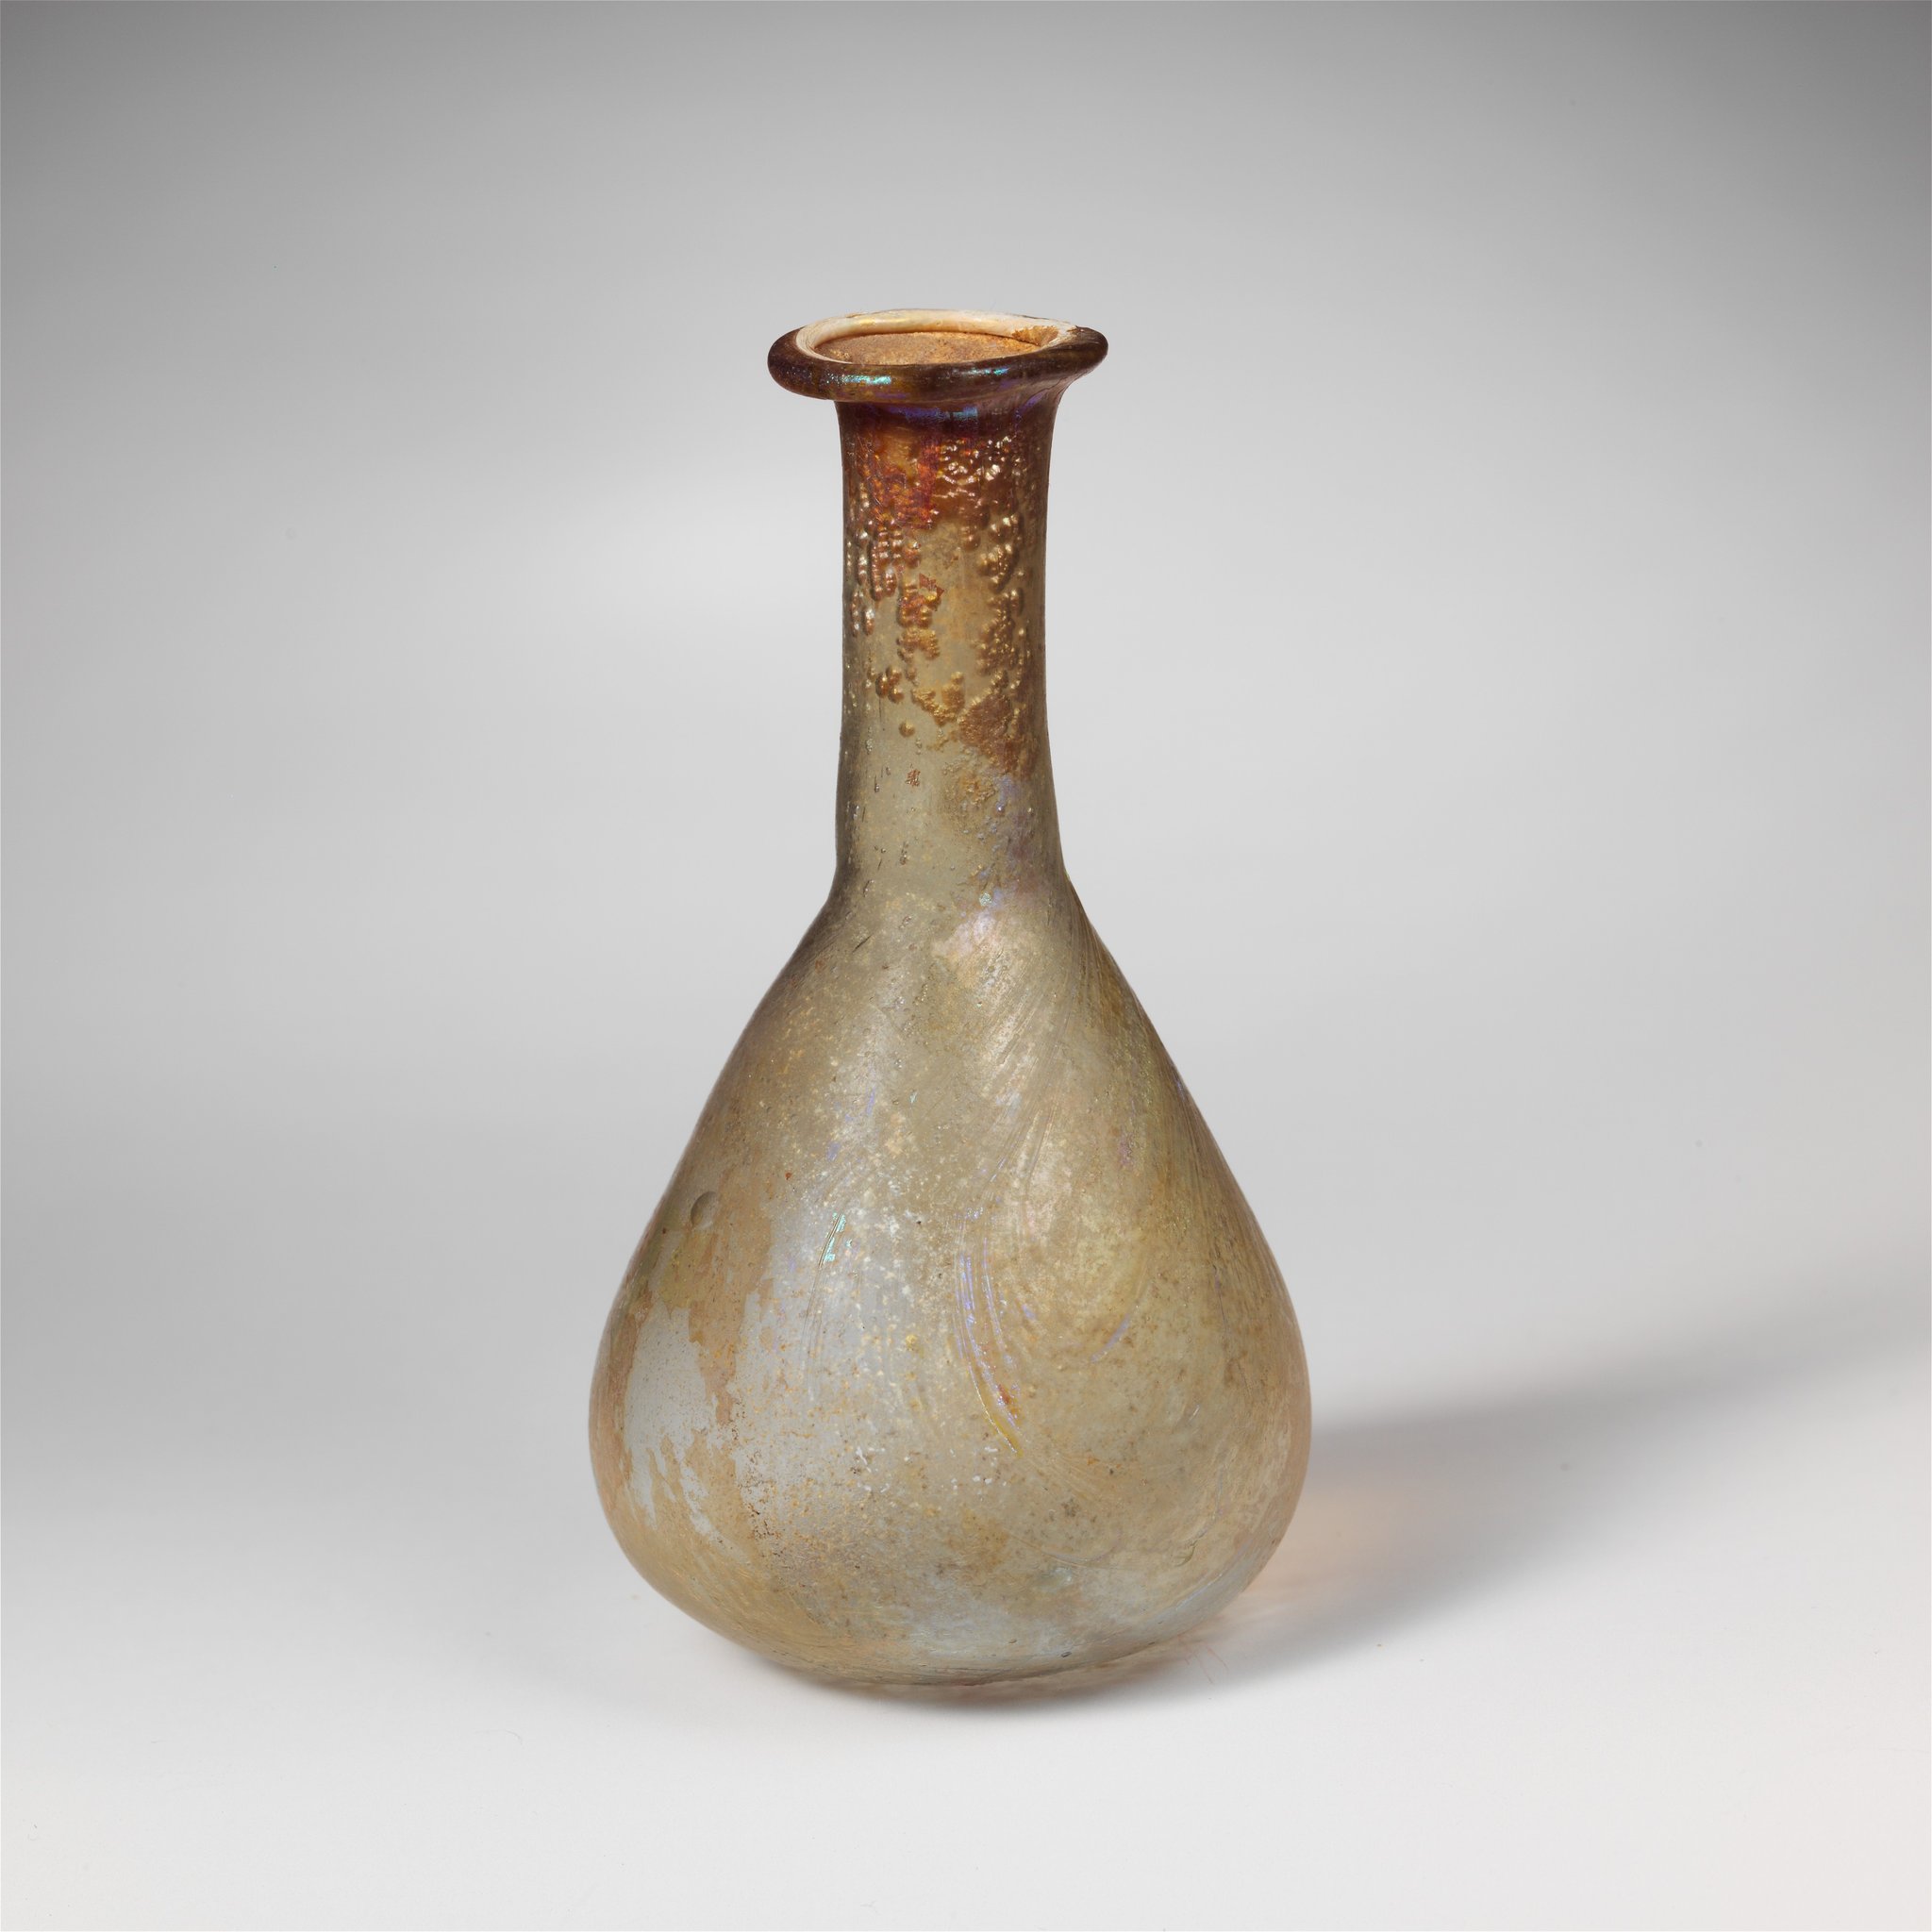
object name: perfume bottle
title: Glass perfume bottle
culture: roman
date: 1-200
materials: glass